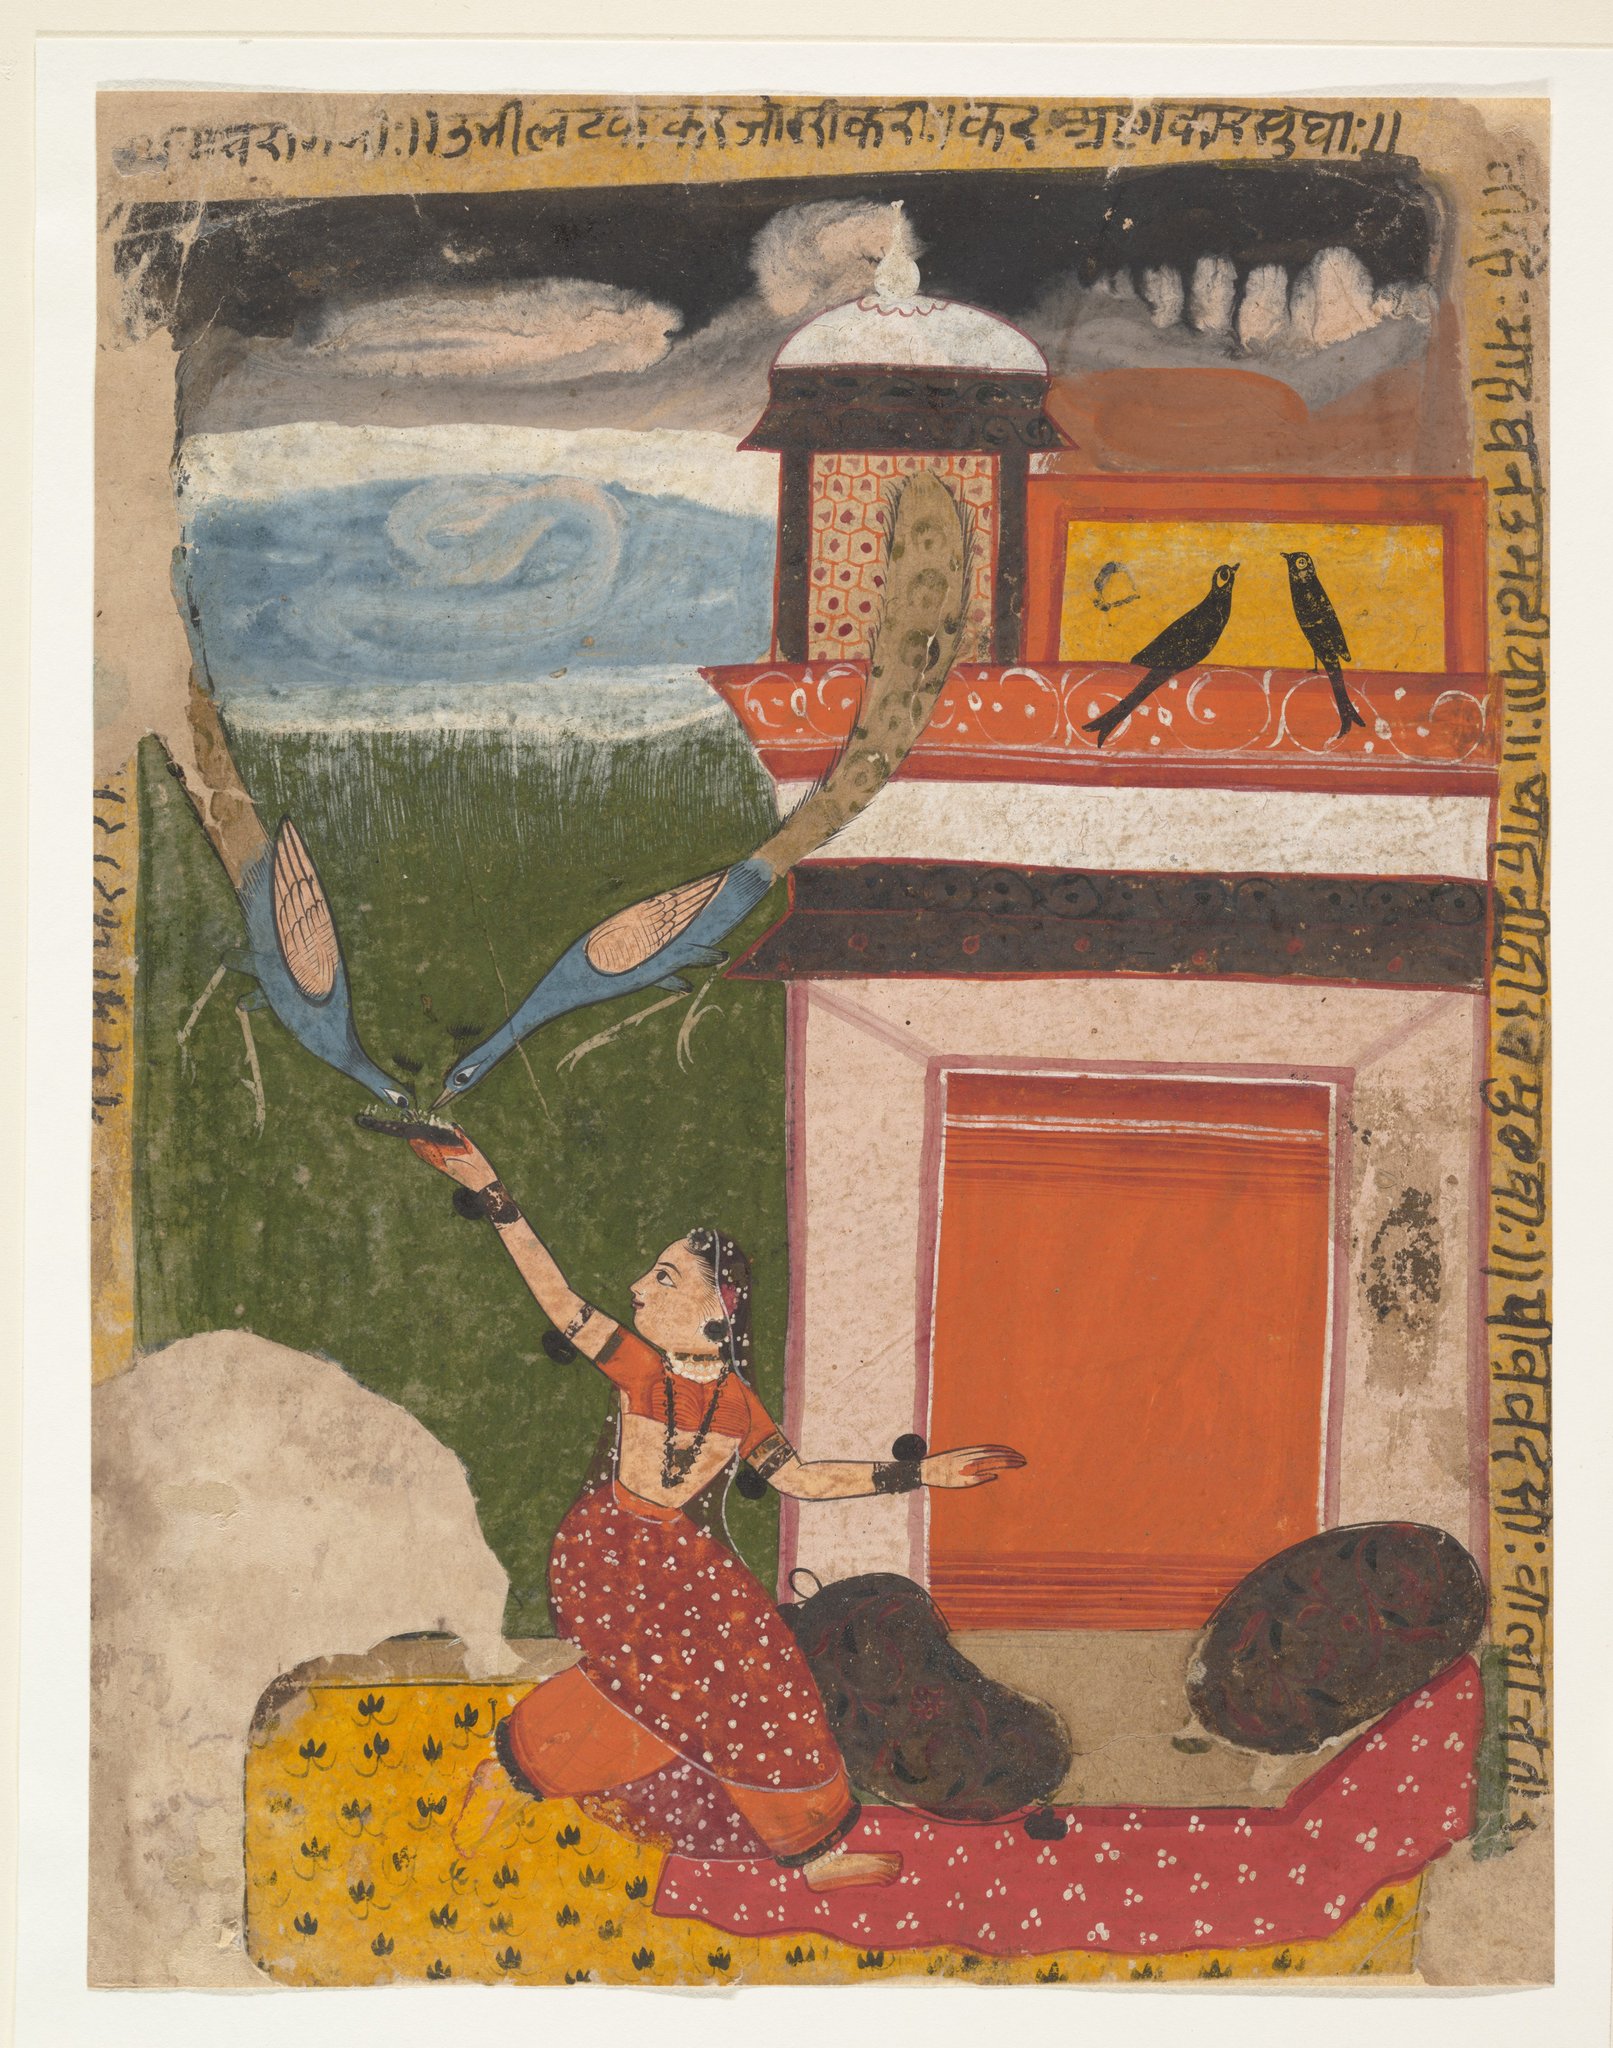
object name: folio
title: Madhumadhavai Ragini: Page from a Dispersed Ragamala Series (Garland of Musical Modes)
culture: indian, rajasthan, marwar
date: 1640-1650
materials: ink, paper, watercolor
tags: birds,women,peacocks